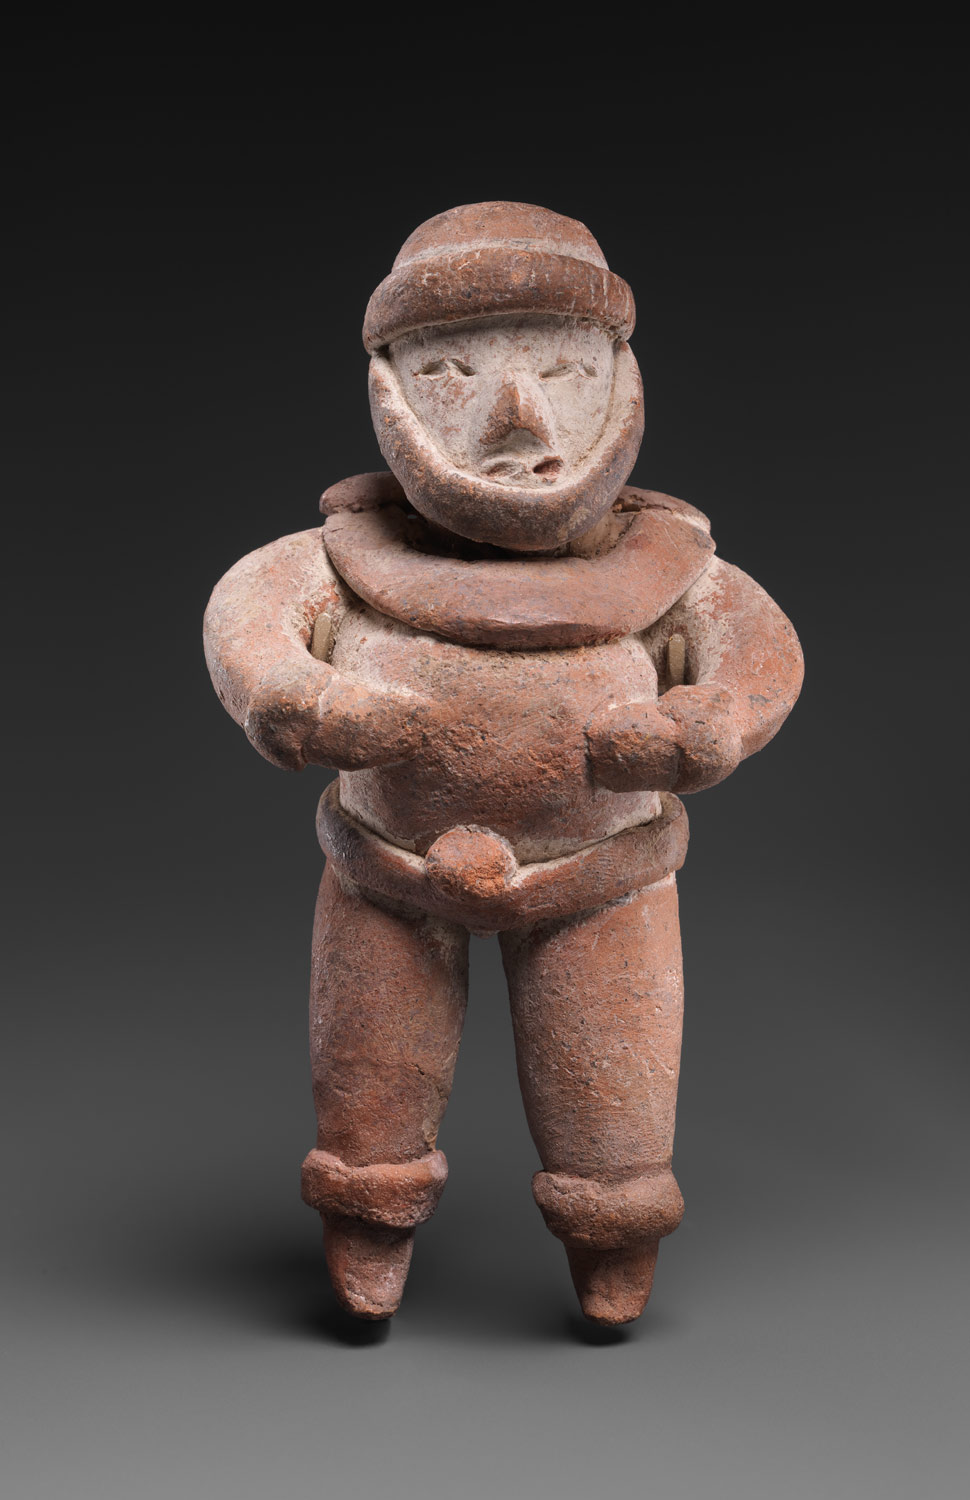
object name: male figure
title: Ballplayer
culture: tlapacoya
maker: tlapacoya artist(s)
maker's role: artist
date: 1200-1000 BCE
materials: ceramic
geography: mexico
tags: human figures